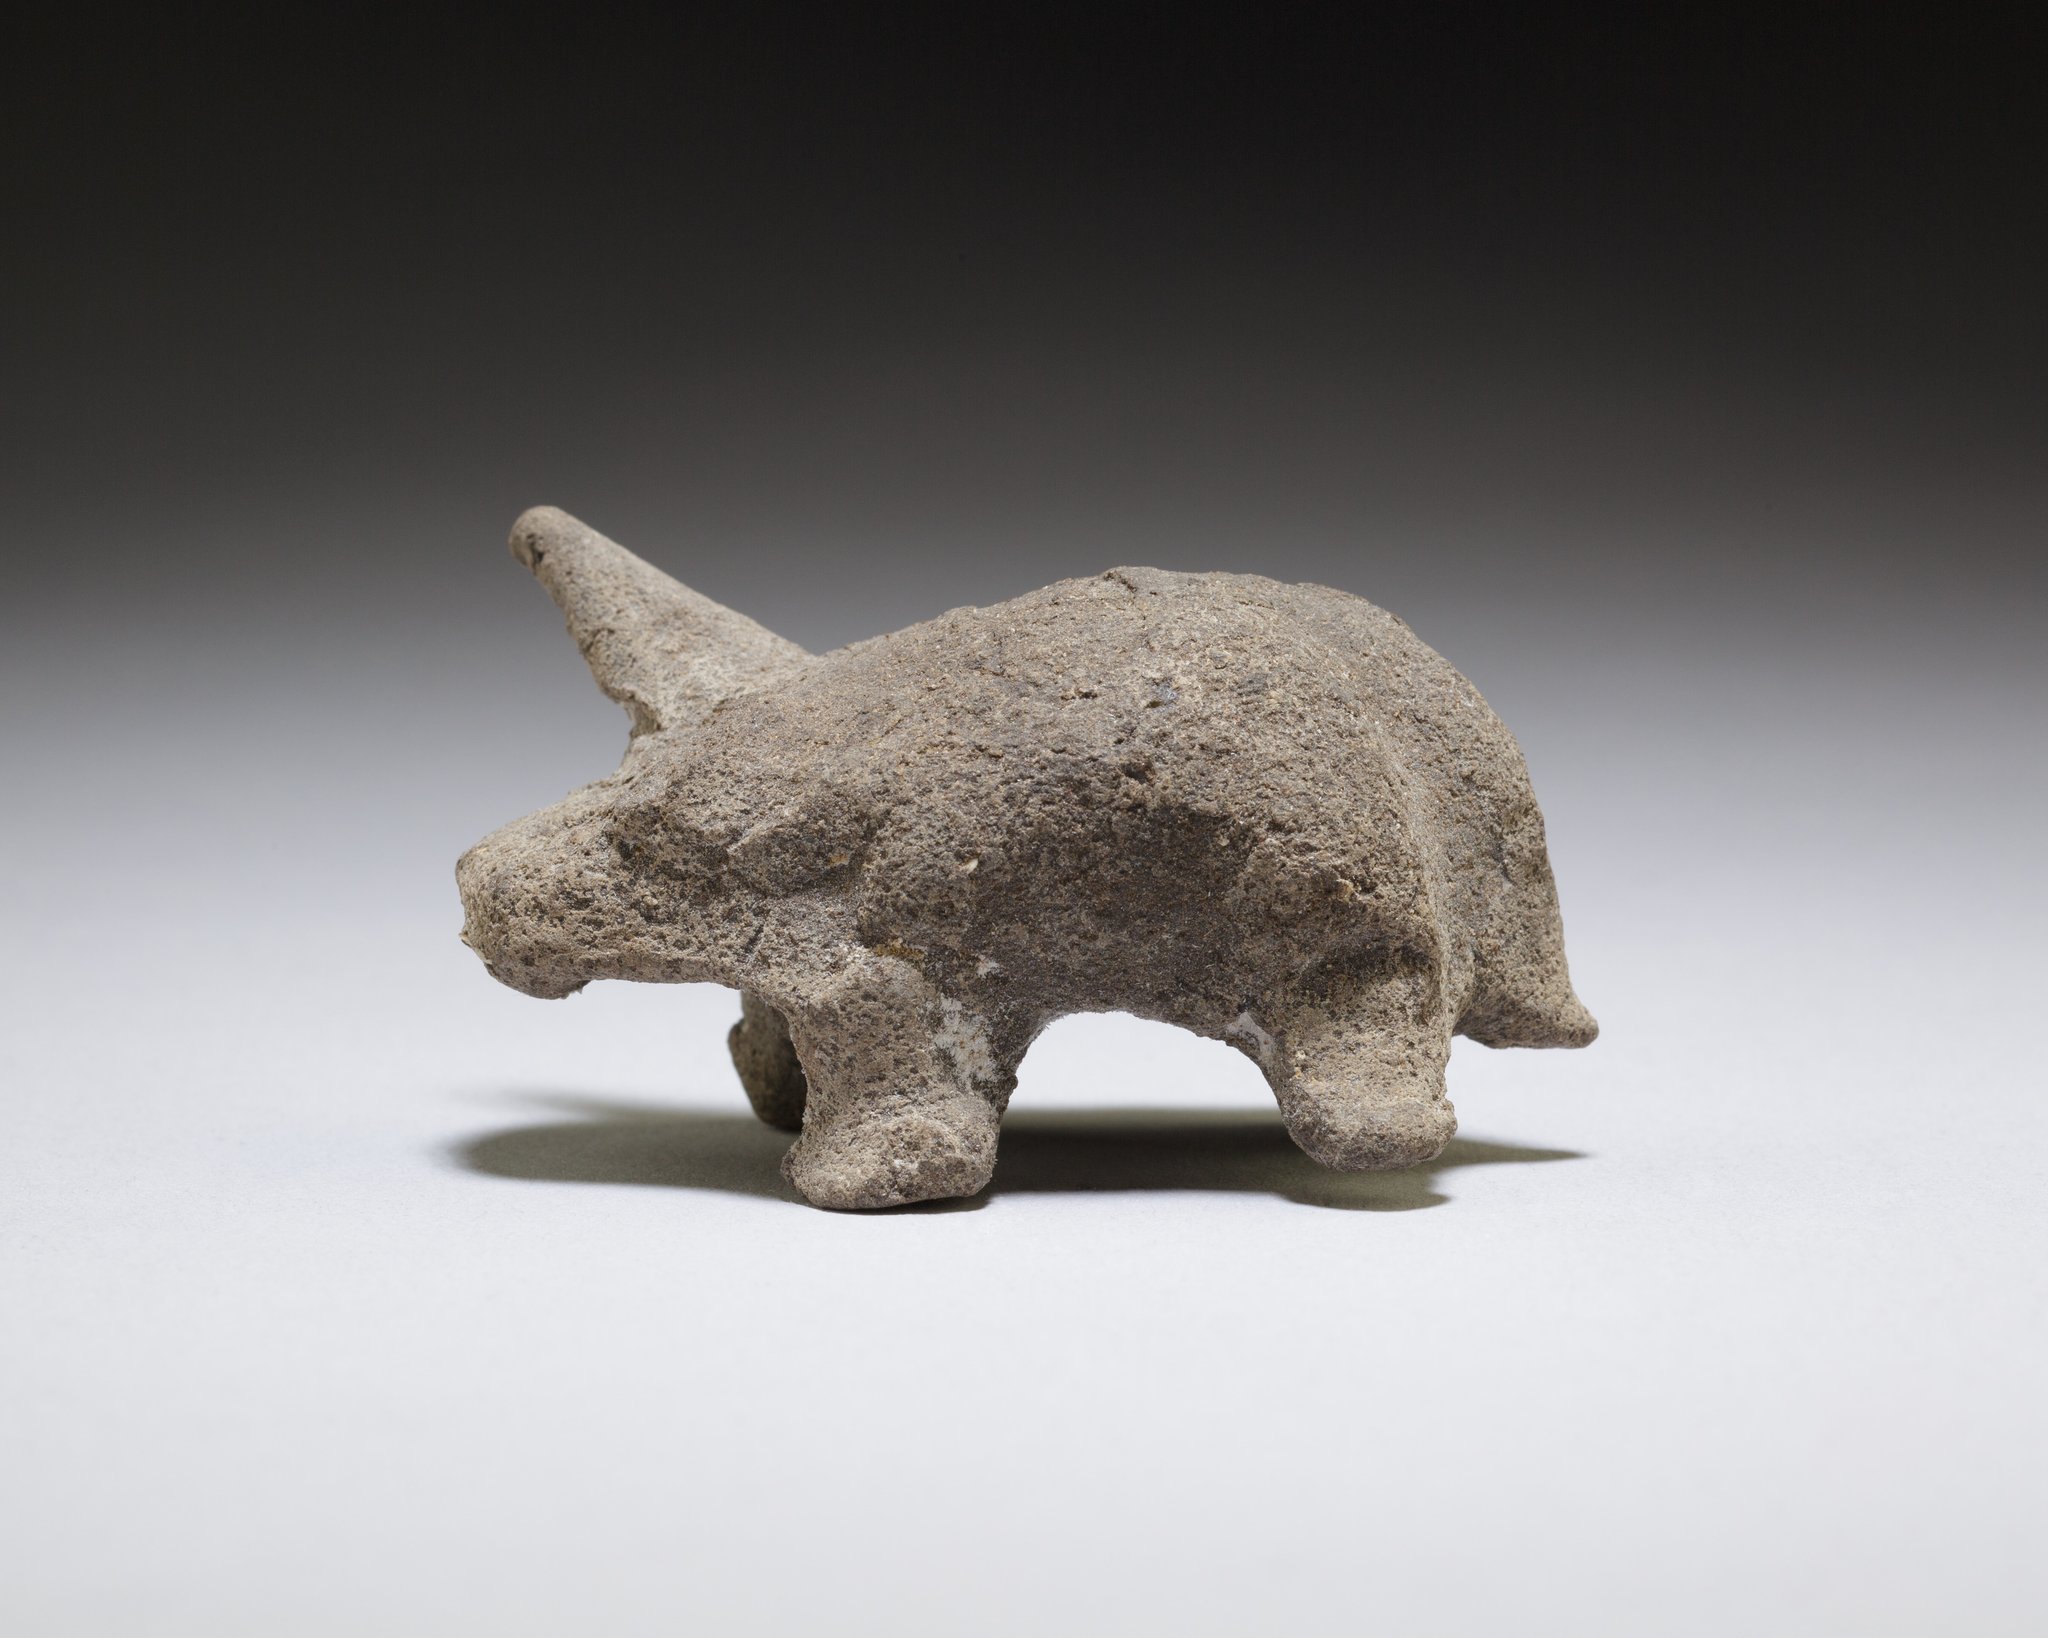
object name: figurine, animal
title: Animal figurine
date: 1981-1640 BCE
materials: clay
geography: egypt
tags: animals